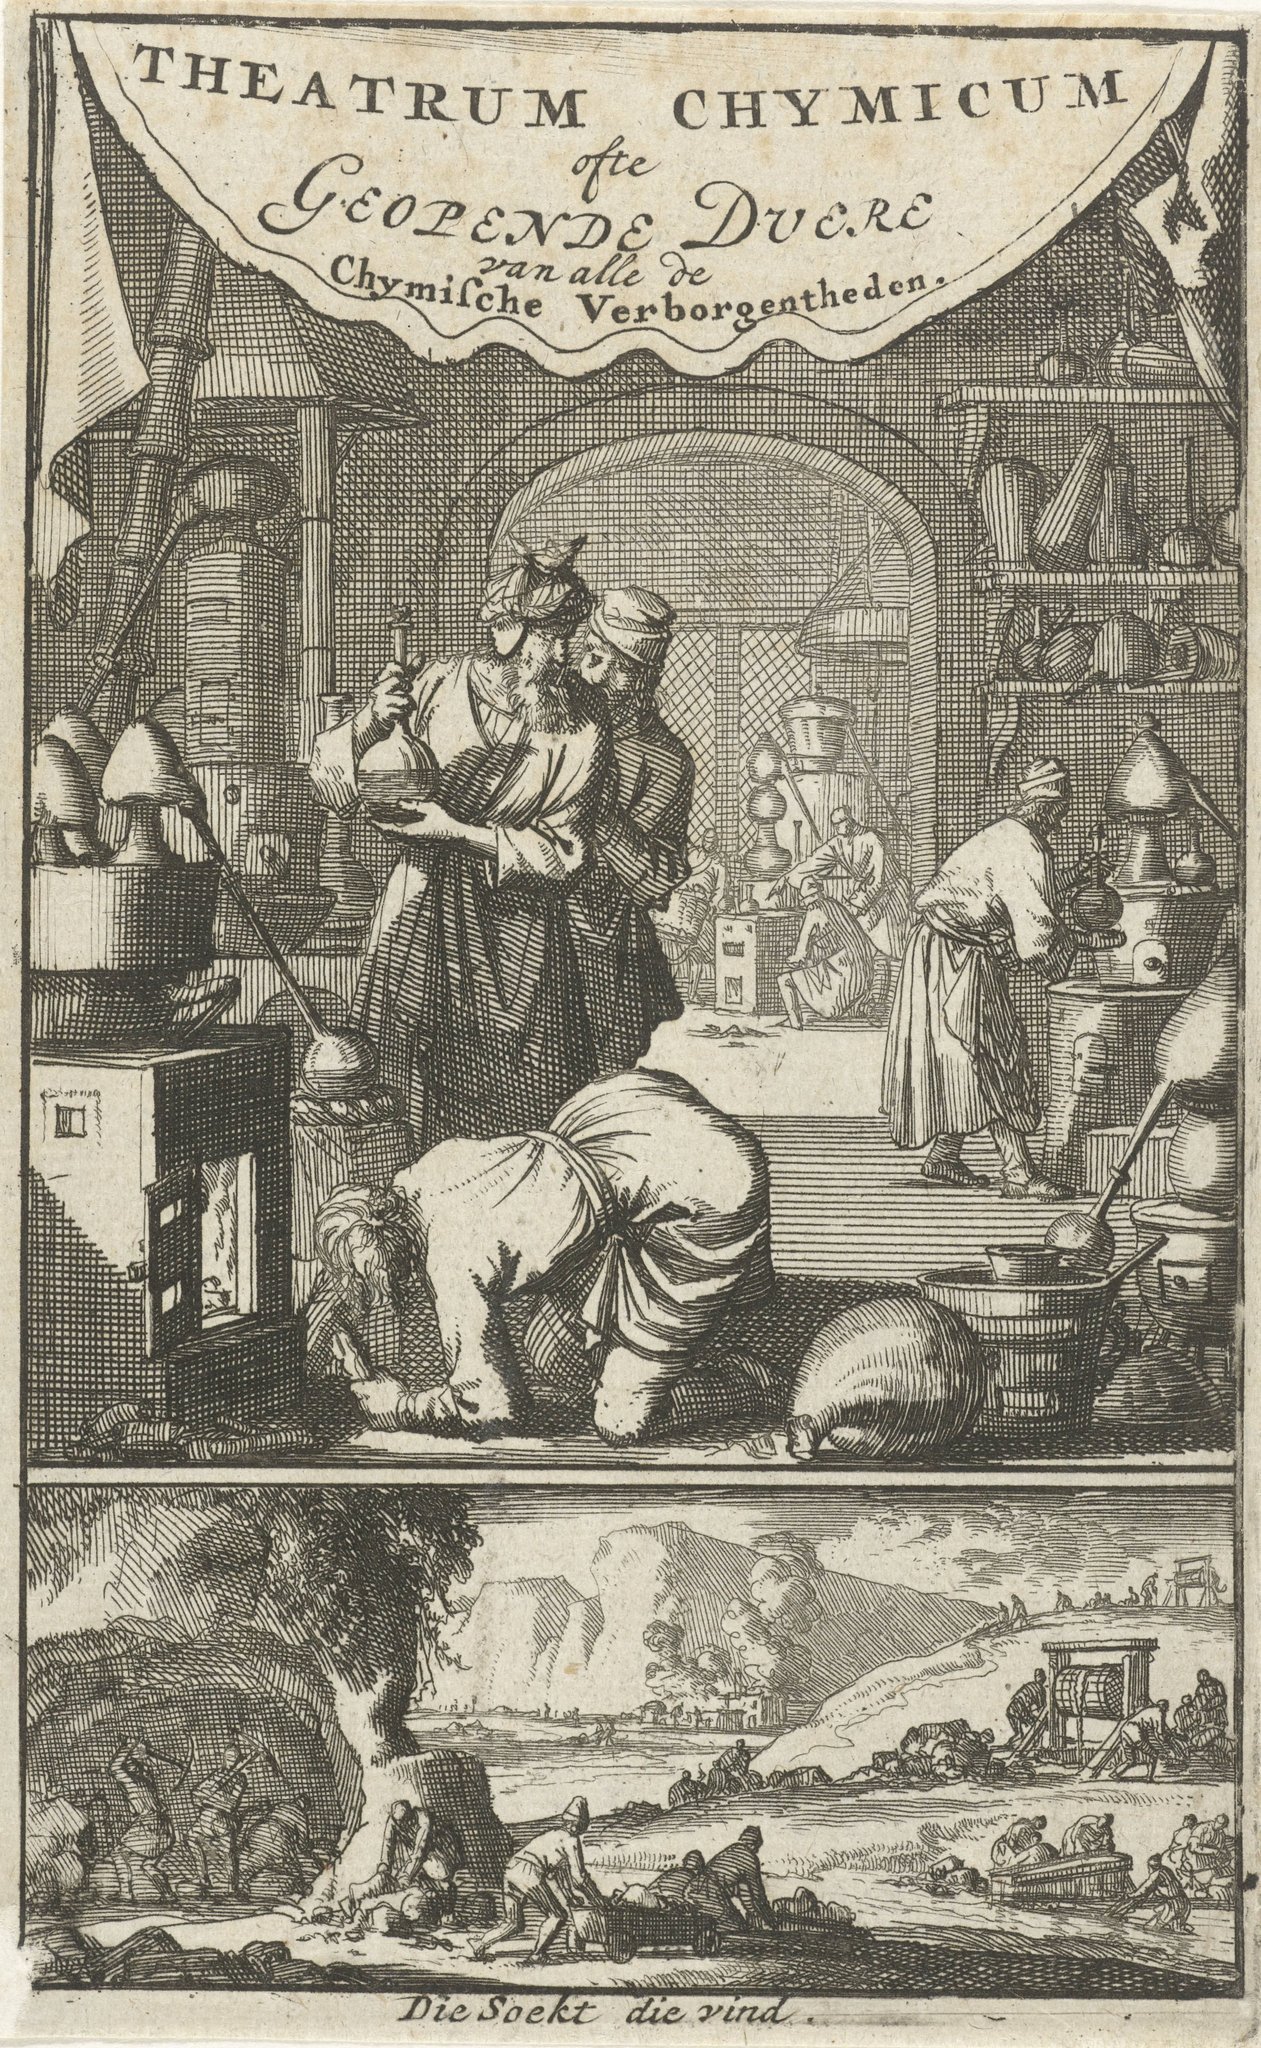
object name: titelblad, titelpagina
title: Titelpagina voor: S. Blankaart, Theatrum chimicum, ofte Geopende deure der chymische verborgentheden, 1693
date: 1693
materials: paper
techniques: etching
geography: amsterdam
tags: quarry, laboratory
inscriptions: collector's mark: Lugt 2228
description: Een laboratorium waar een aantal figuren aan fornuizen met distilleertoestellen proeven doet. Onder de hoofdvoorstelling de weergave van een landschap met werklieden bij een steengroeve.